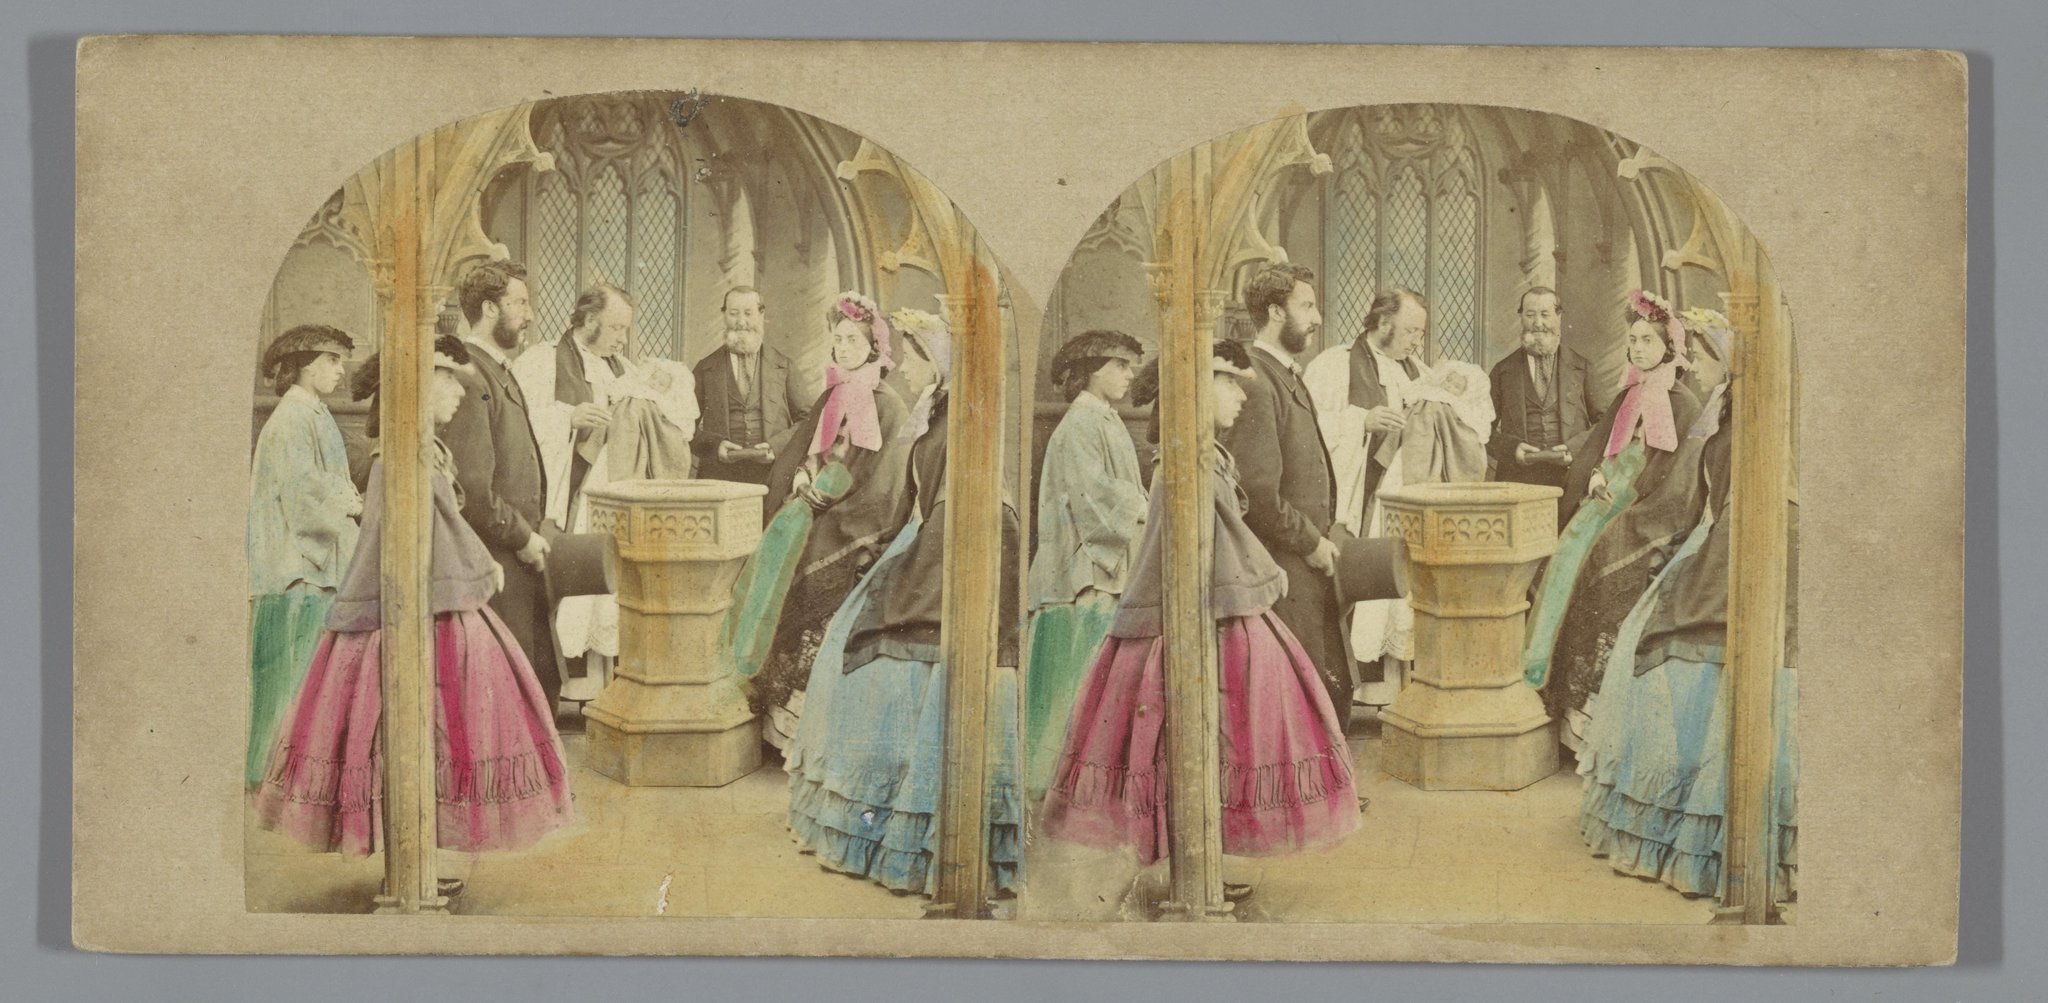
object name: stereograph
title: The Christening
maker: Anonymous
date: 1852-1863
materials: cardboard, paper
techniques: albumen print, hand coloring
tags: baptism, christening ceremony ~ the first of the seven sacraments, parts of church interior